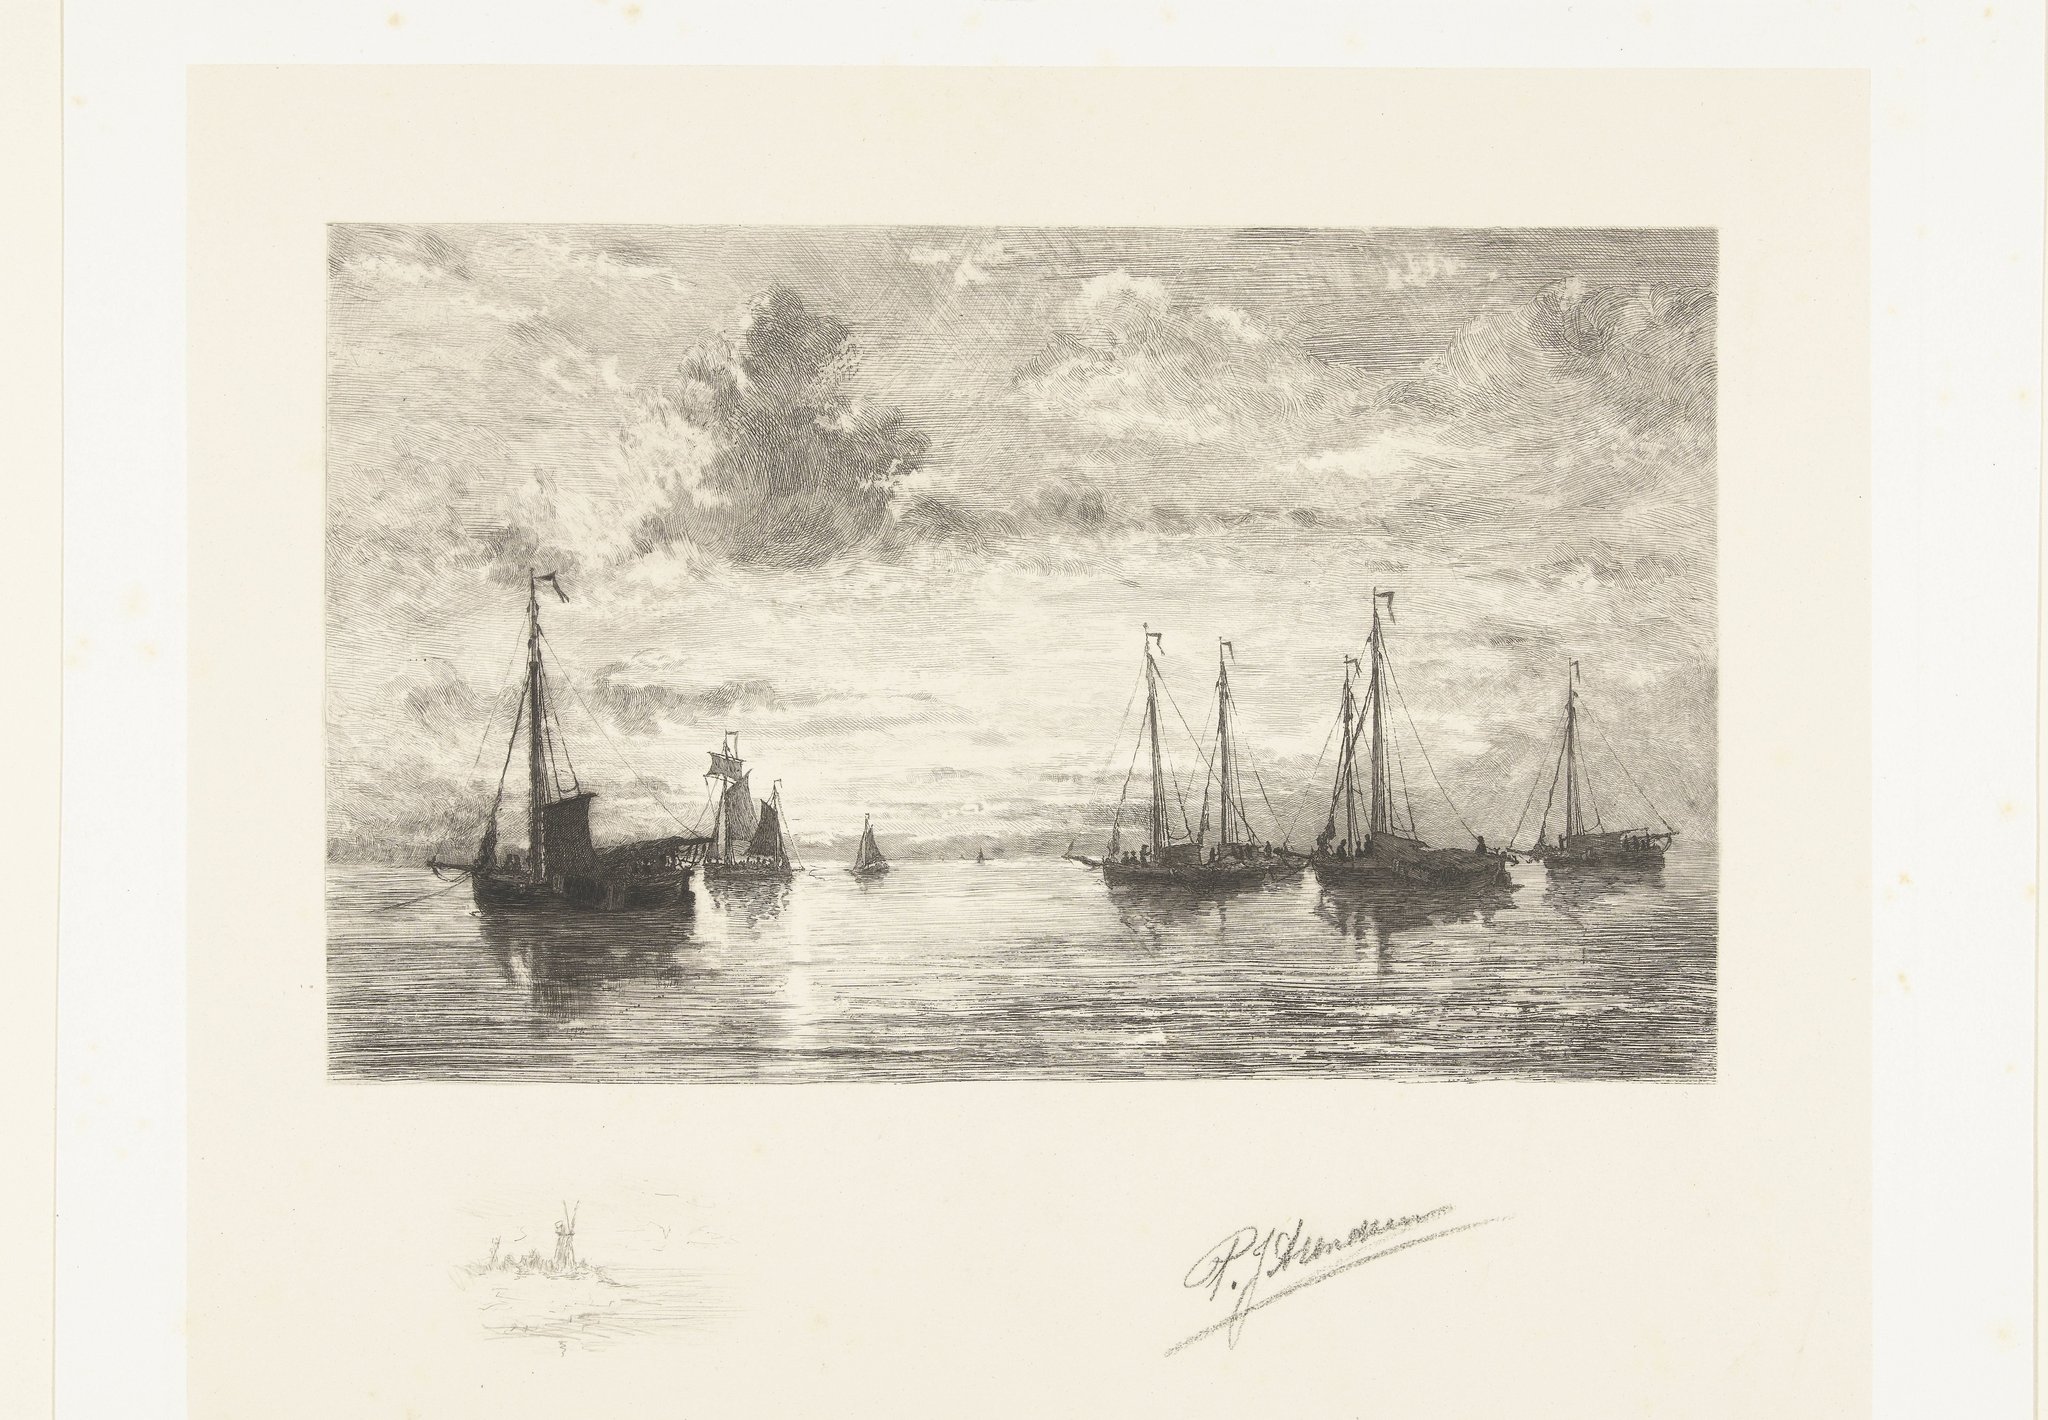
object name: print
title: Visschersschepen op zee bij opgaande zon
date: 1856-1900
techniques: printmaking, etching, roulette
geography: netherlands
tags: sailing-ship, sailing-boat, sea (seascape)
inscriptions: collector's mark: Lugt 2228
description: Visschersschepen op zee bij opgaande zon. In marge een molen aan zee.